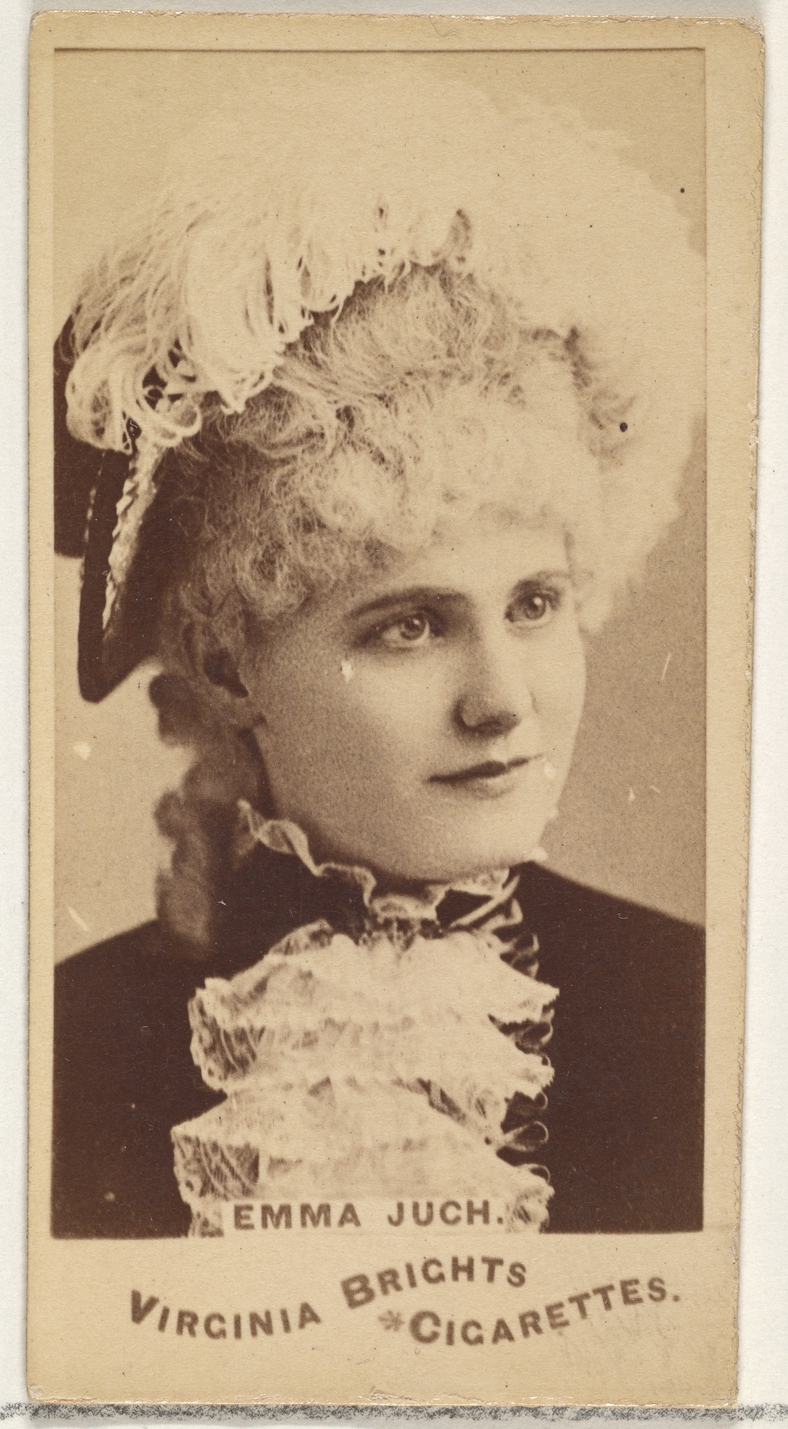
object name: photograph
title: Emma Juch, from the Actors and Actresses series (N45, Type 1) for Virginia Brights Cigarettes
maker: allen & ginter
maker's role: publisher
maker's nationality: american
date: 1888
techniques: albumen silver print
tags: portraits,women,actresses